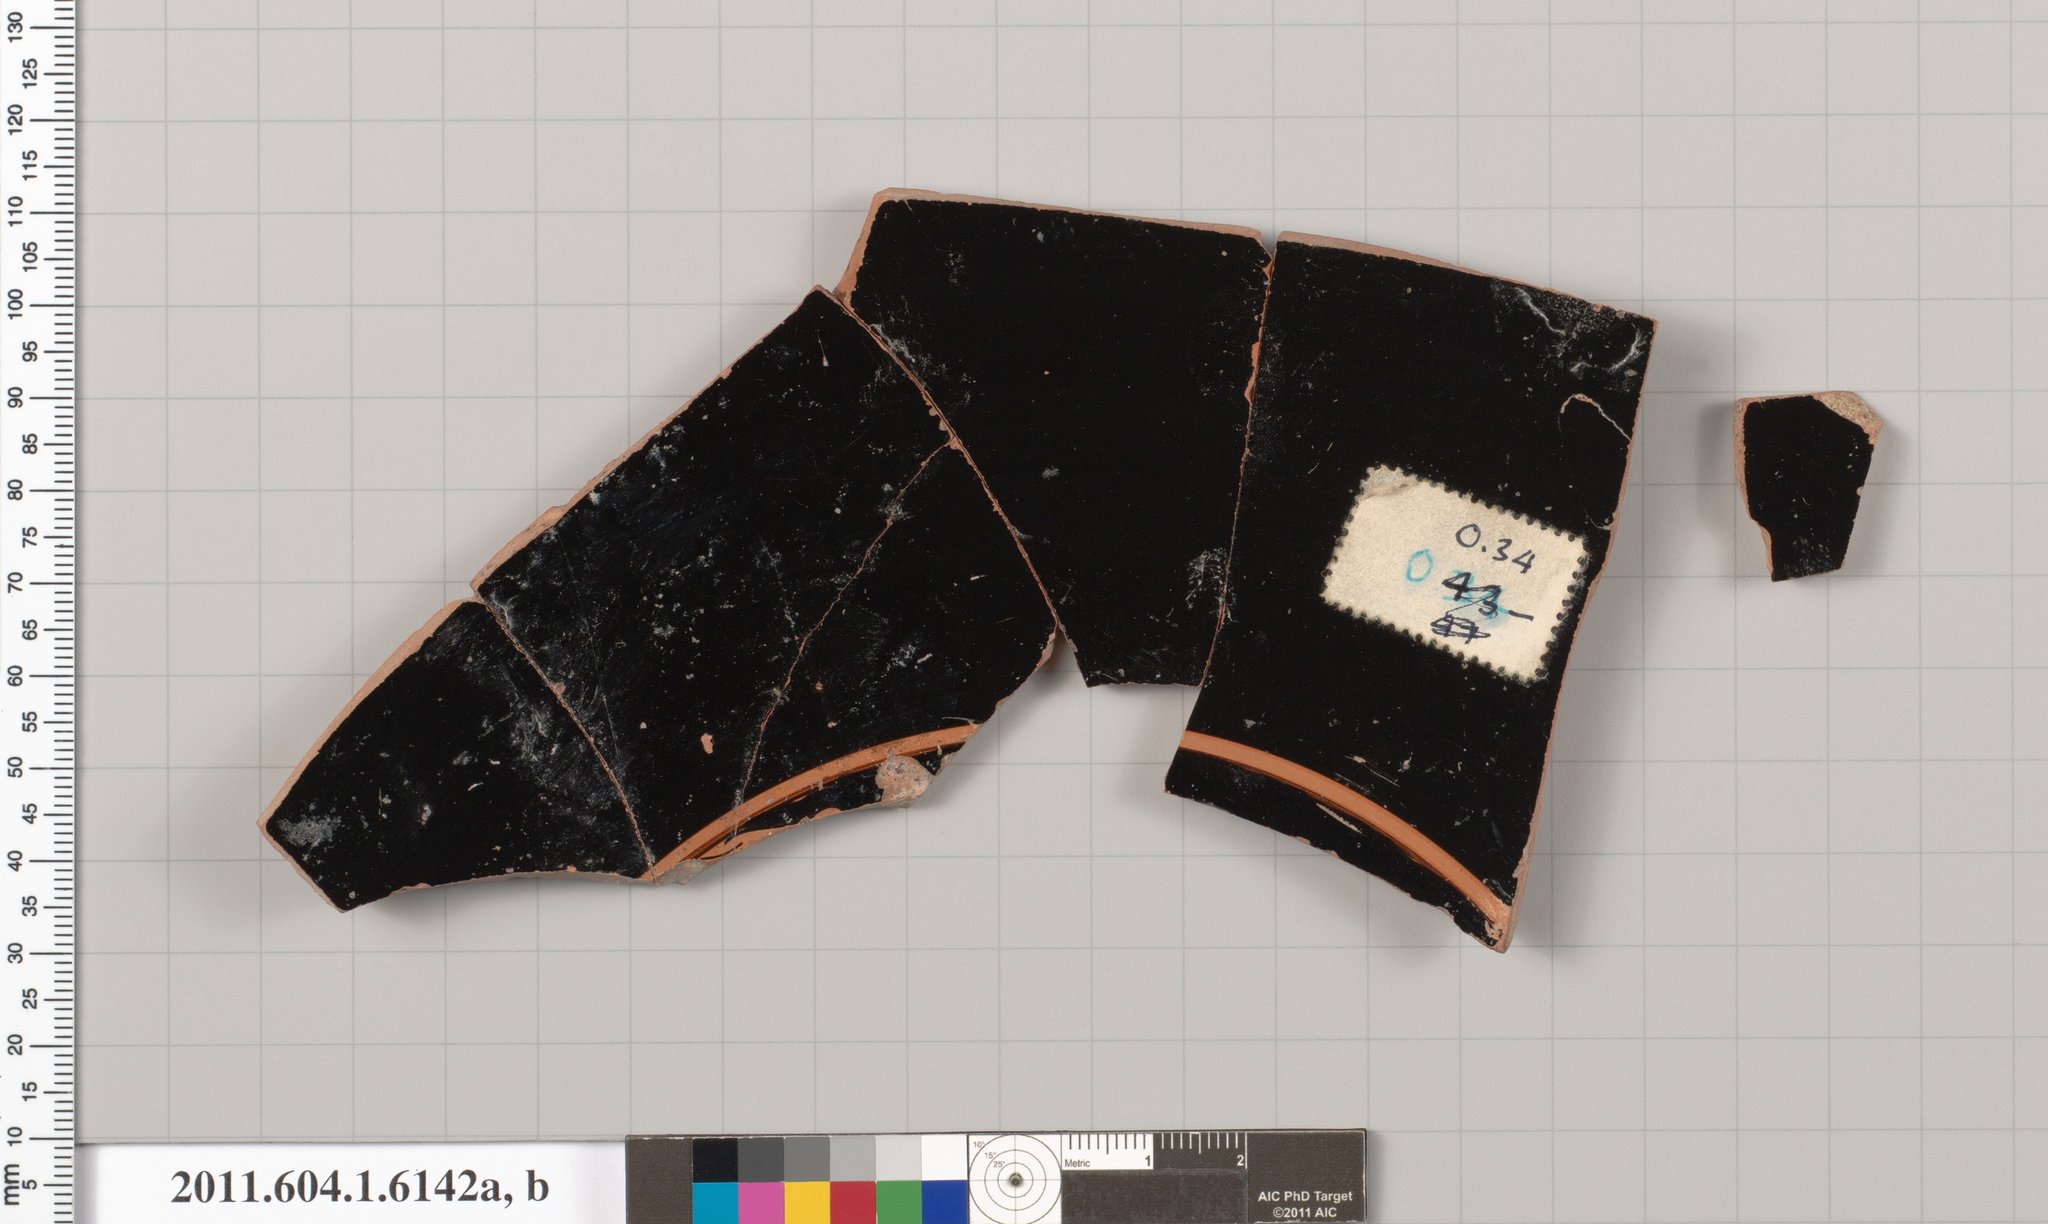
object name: kylix fragment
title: Terracotta fragments of a kylix (drinking cup)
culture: greek, attic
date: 520-500 BCE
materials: terracotta